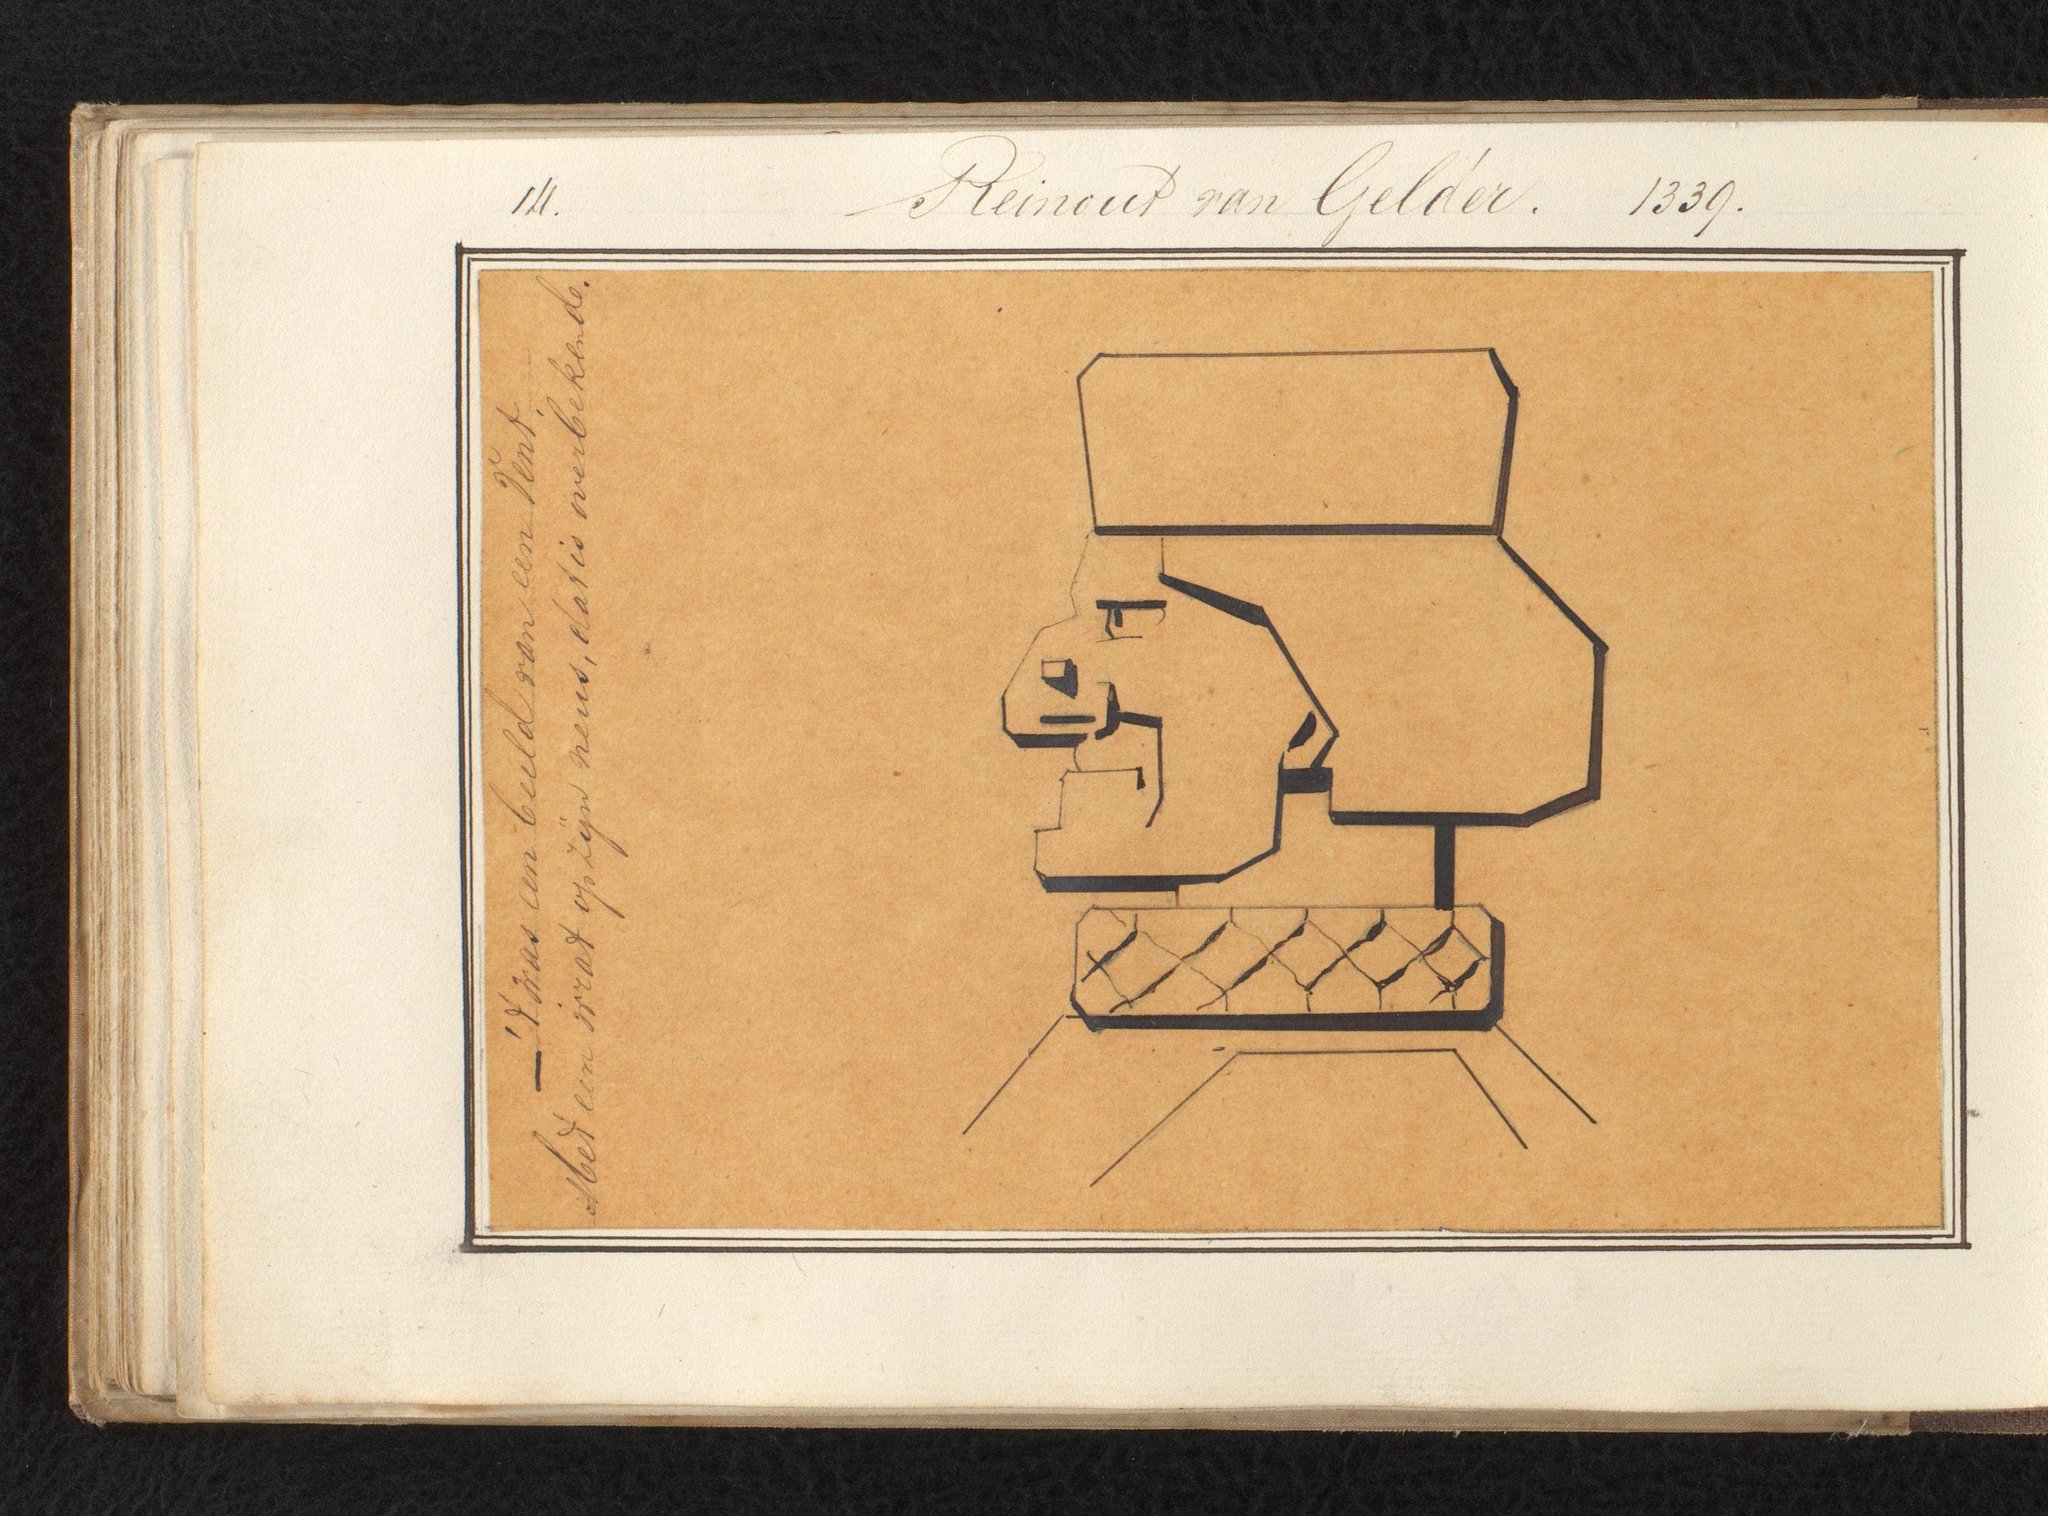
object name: boekillustratie ontwerp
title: Portret van Reinout, hertog van Gelre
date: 1853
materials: ink, pencil, paper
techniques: pen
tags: historical persons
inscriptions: inscription: ‘'t was een beed van een vent/ met een wrat op zijn neus, dat is overbekend.’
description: Ontwerp voor: Lennep, Jacob van. Tafereelen uit de geschiedenis des vaderlands, tot nut van groot en klein. Amsterdam: M.H. Binger en Zonen, 1854.